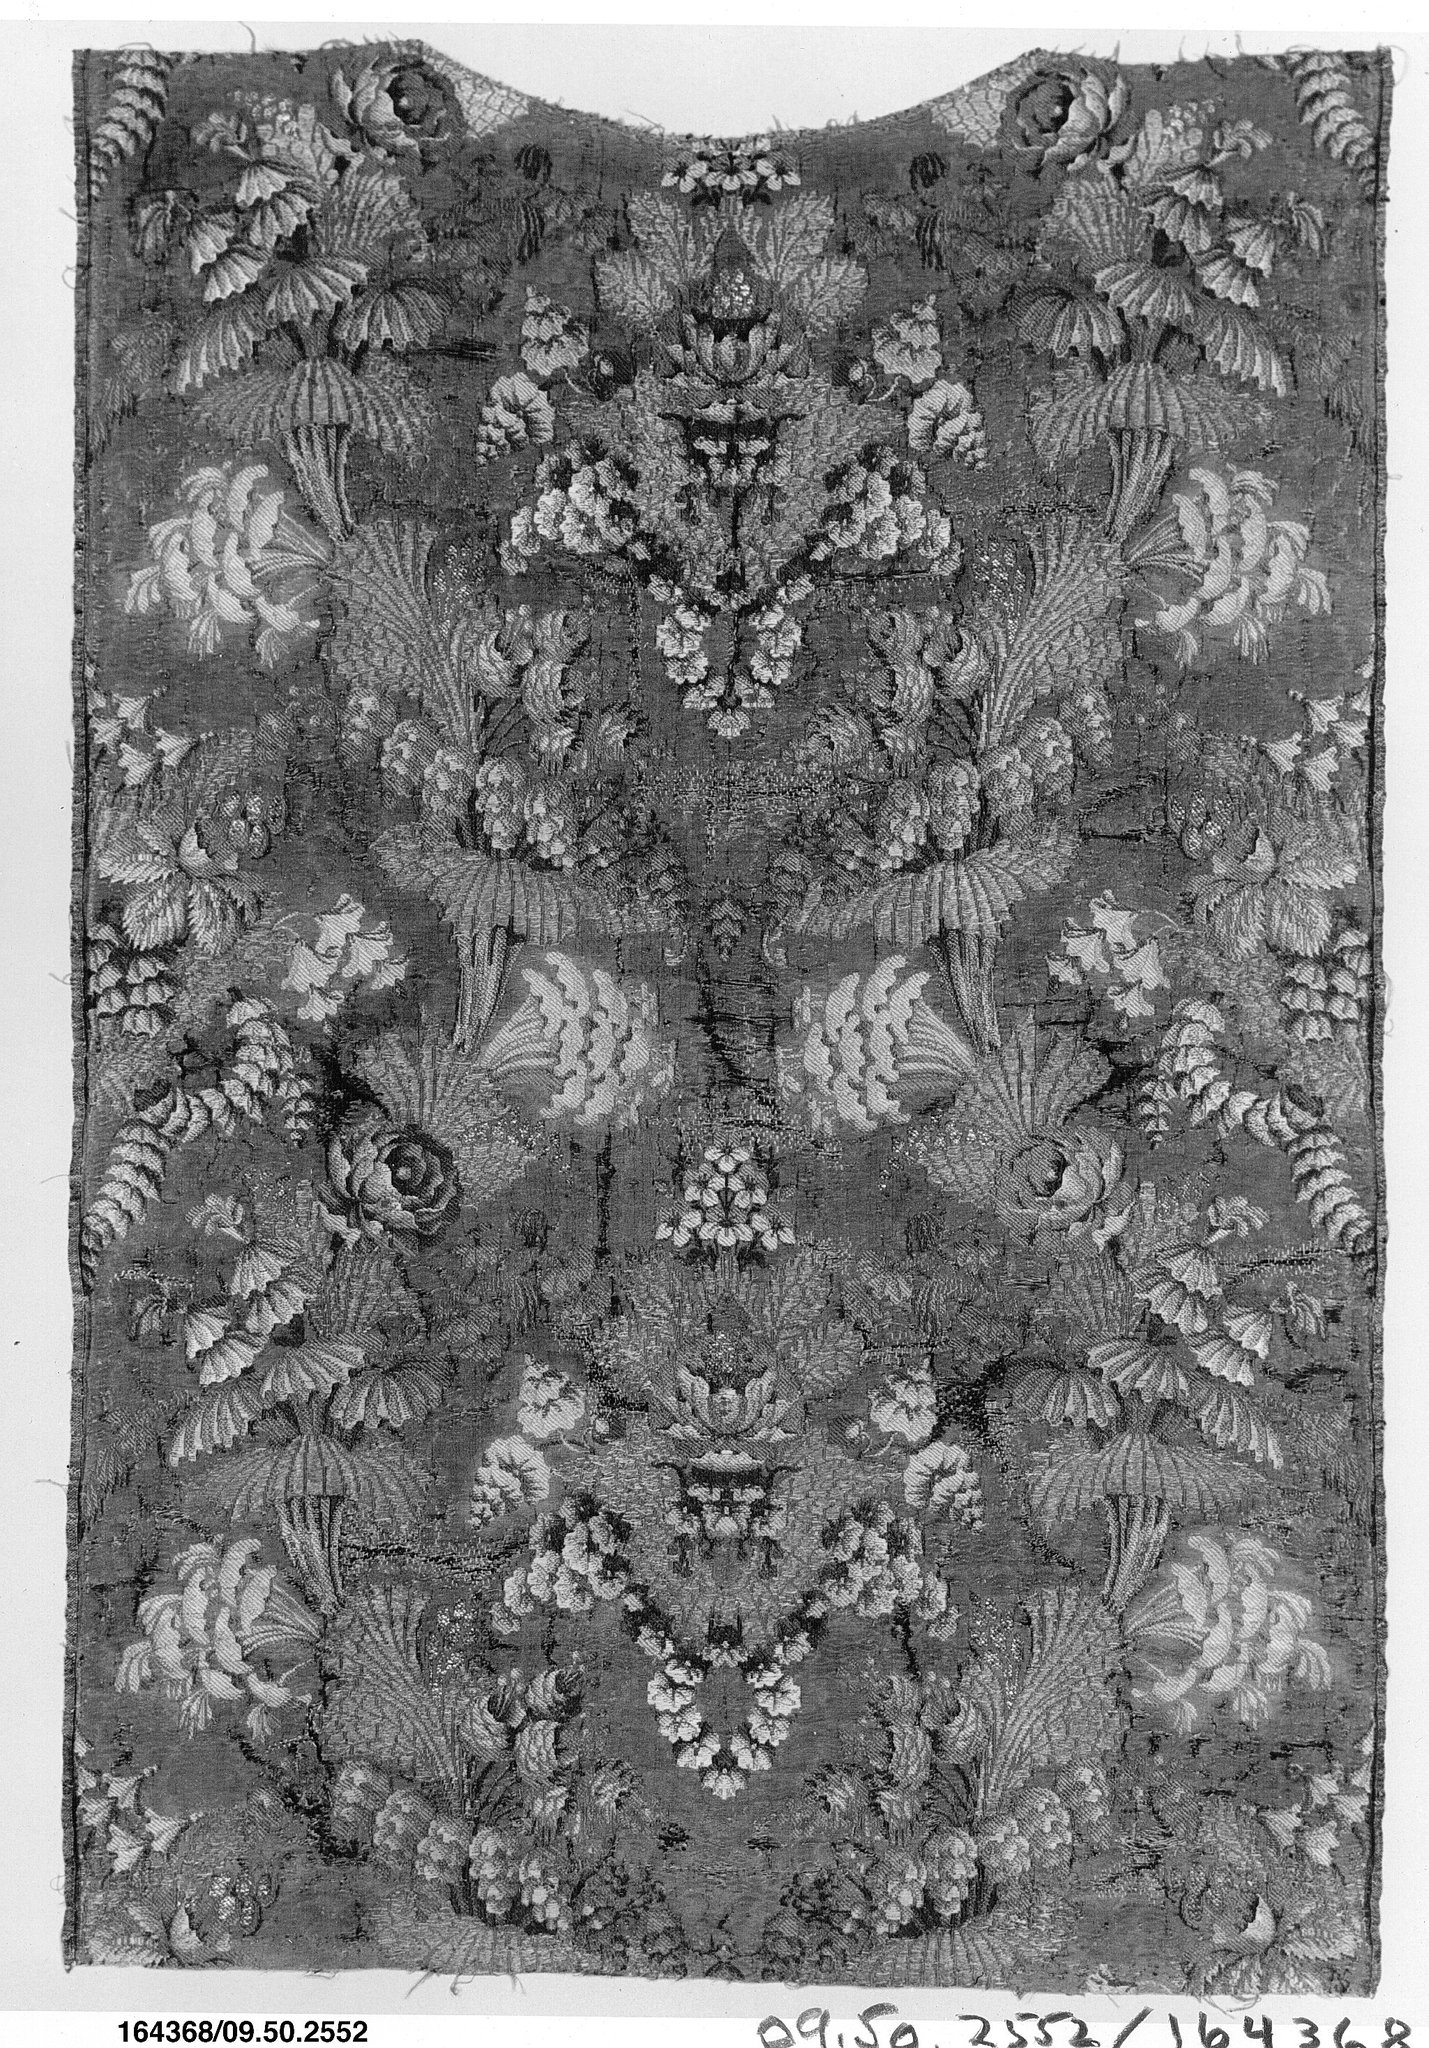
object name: piece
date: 1735-1745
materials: metal thread, silk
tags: flowers,leaves